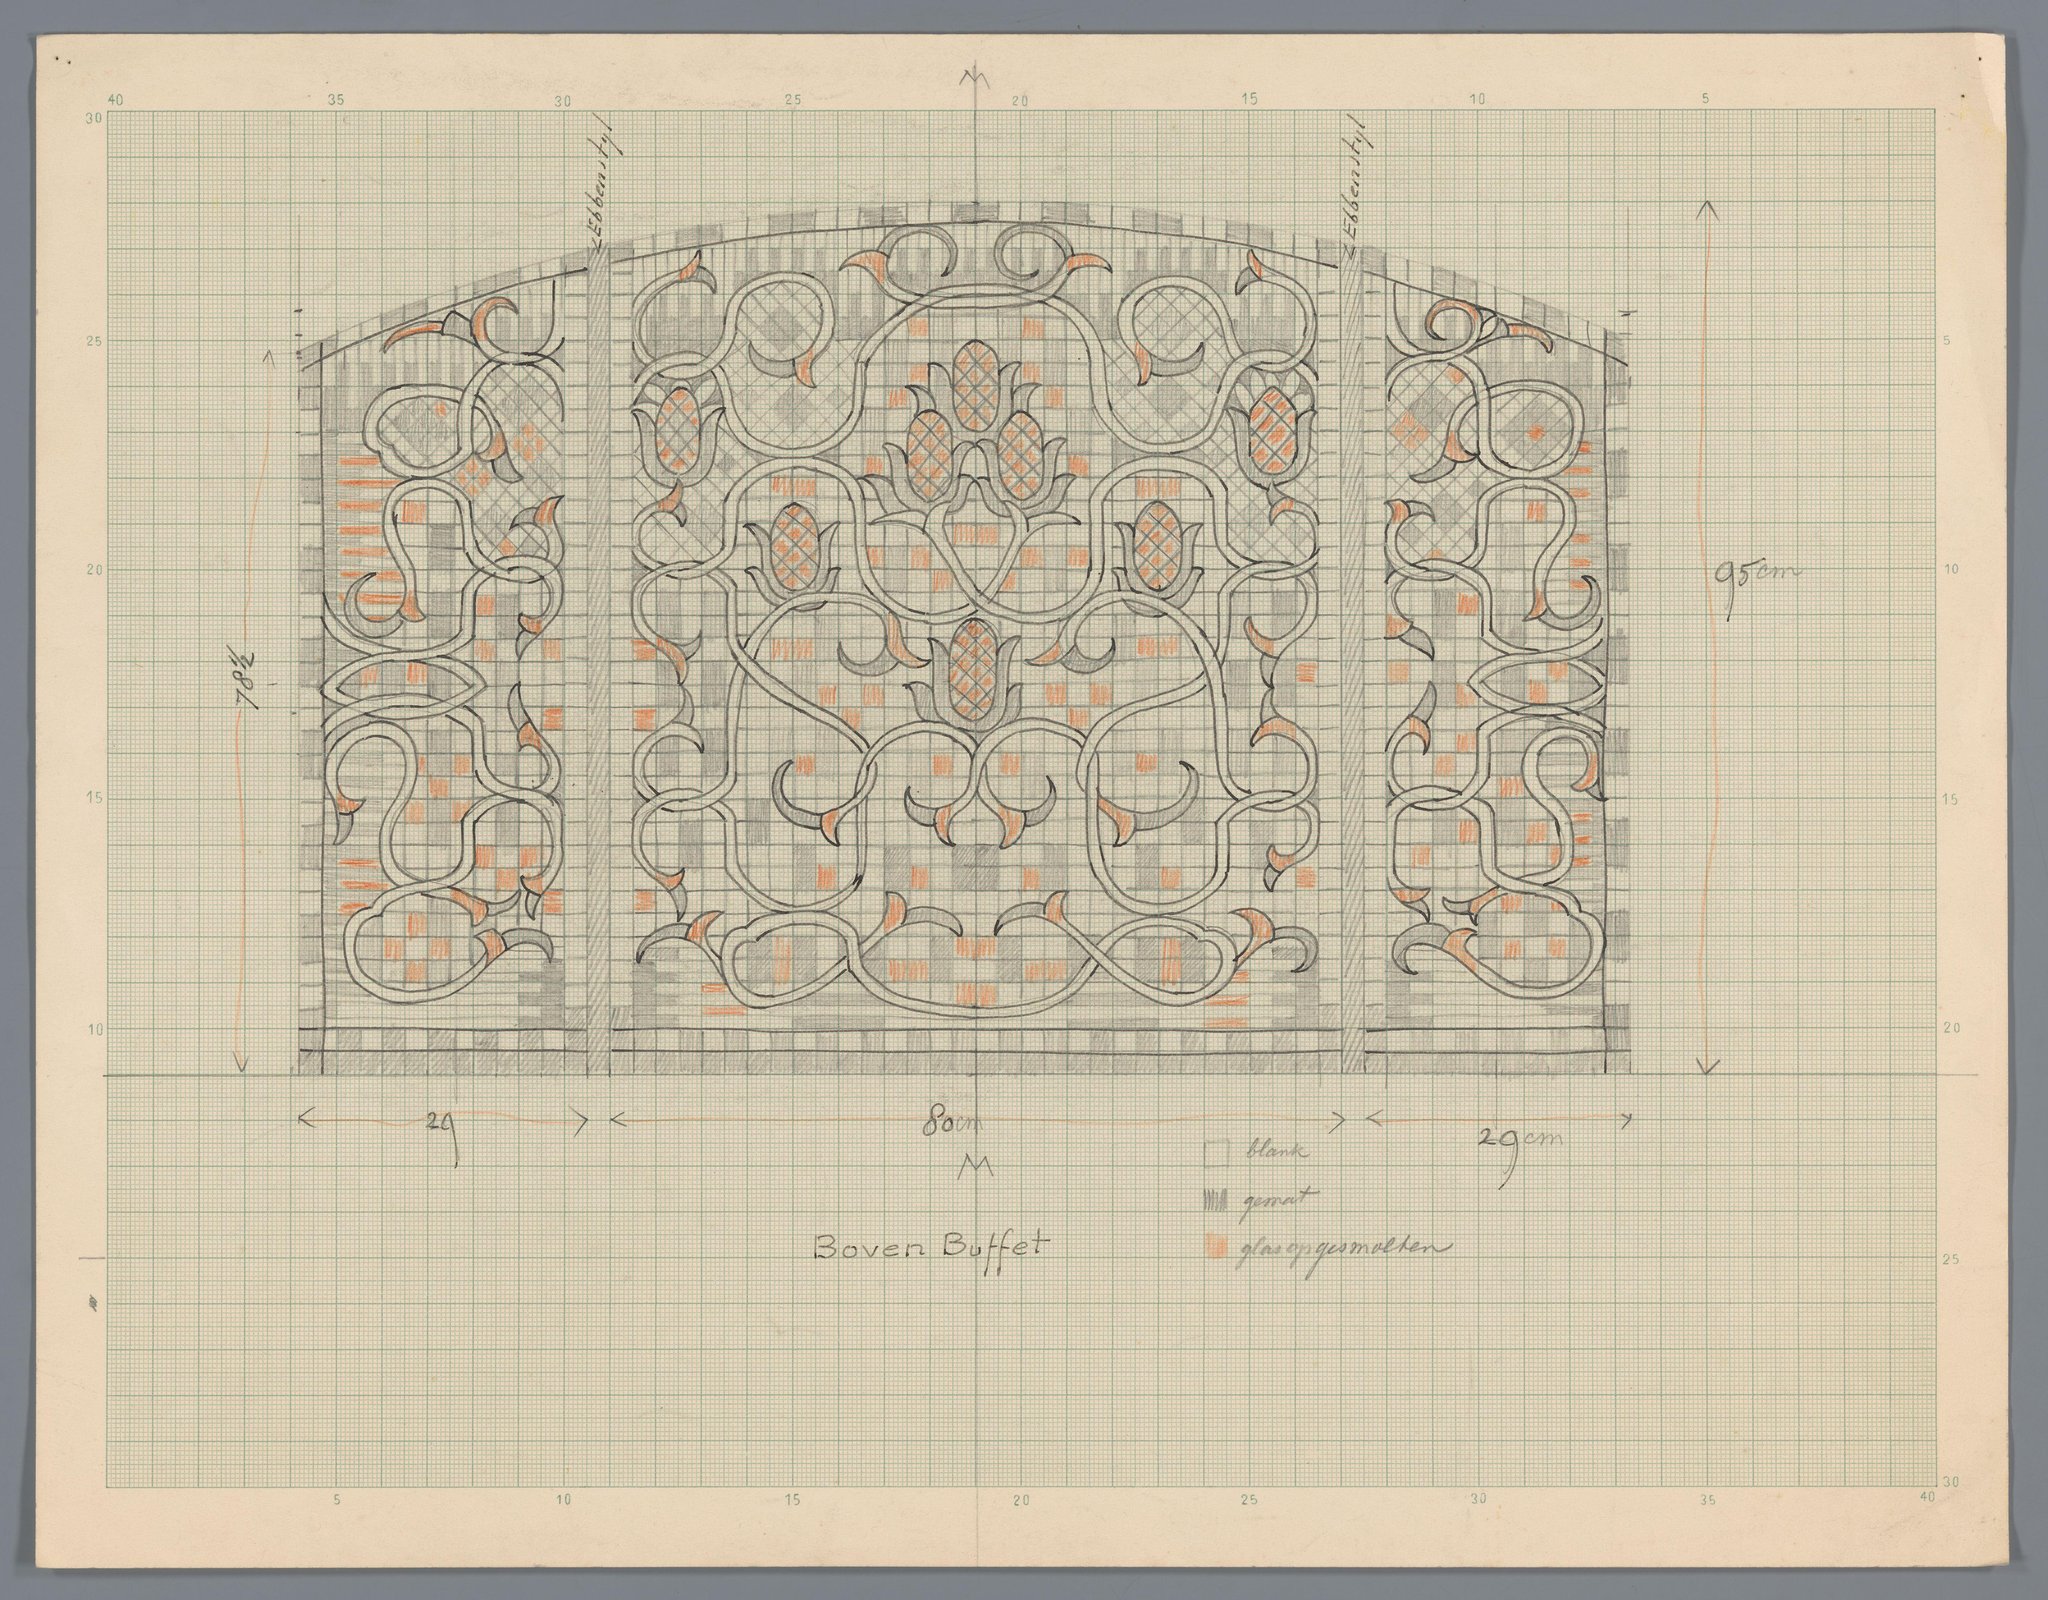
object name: design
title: Ontwerp voor decoratief glaspaneel met floraal ornament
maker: carel adolph lion cachet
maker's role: draughtsman, print maker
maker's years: 1864-1945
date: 1874-1945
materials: ink, pencil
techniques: pen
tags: furniture and household effects, ornament derived from plant forms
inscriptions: inscription: ‘Boven Buffet’